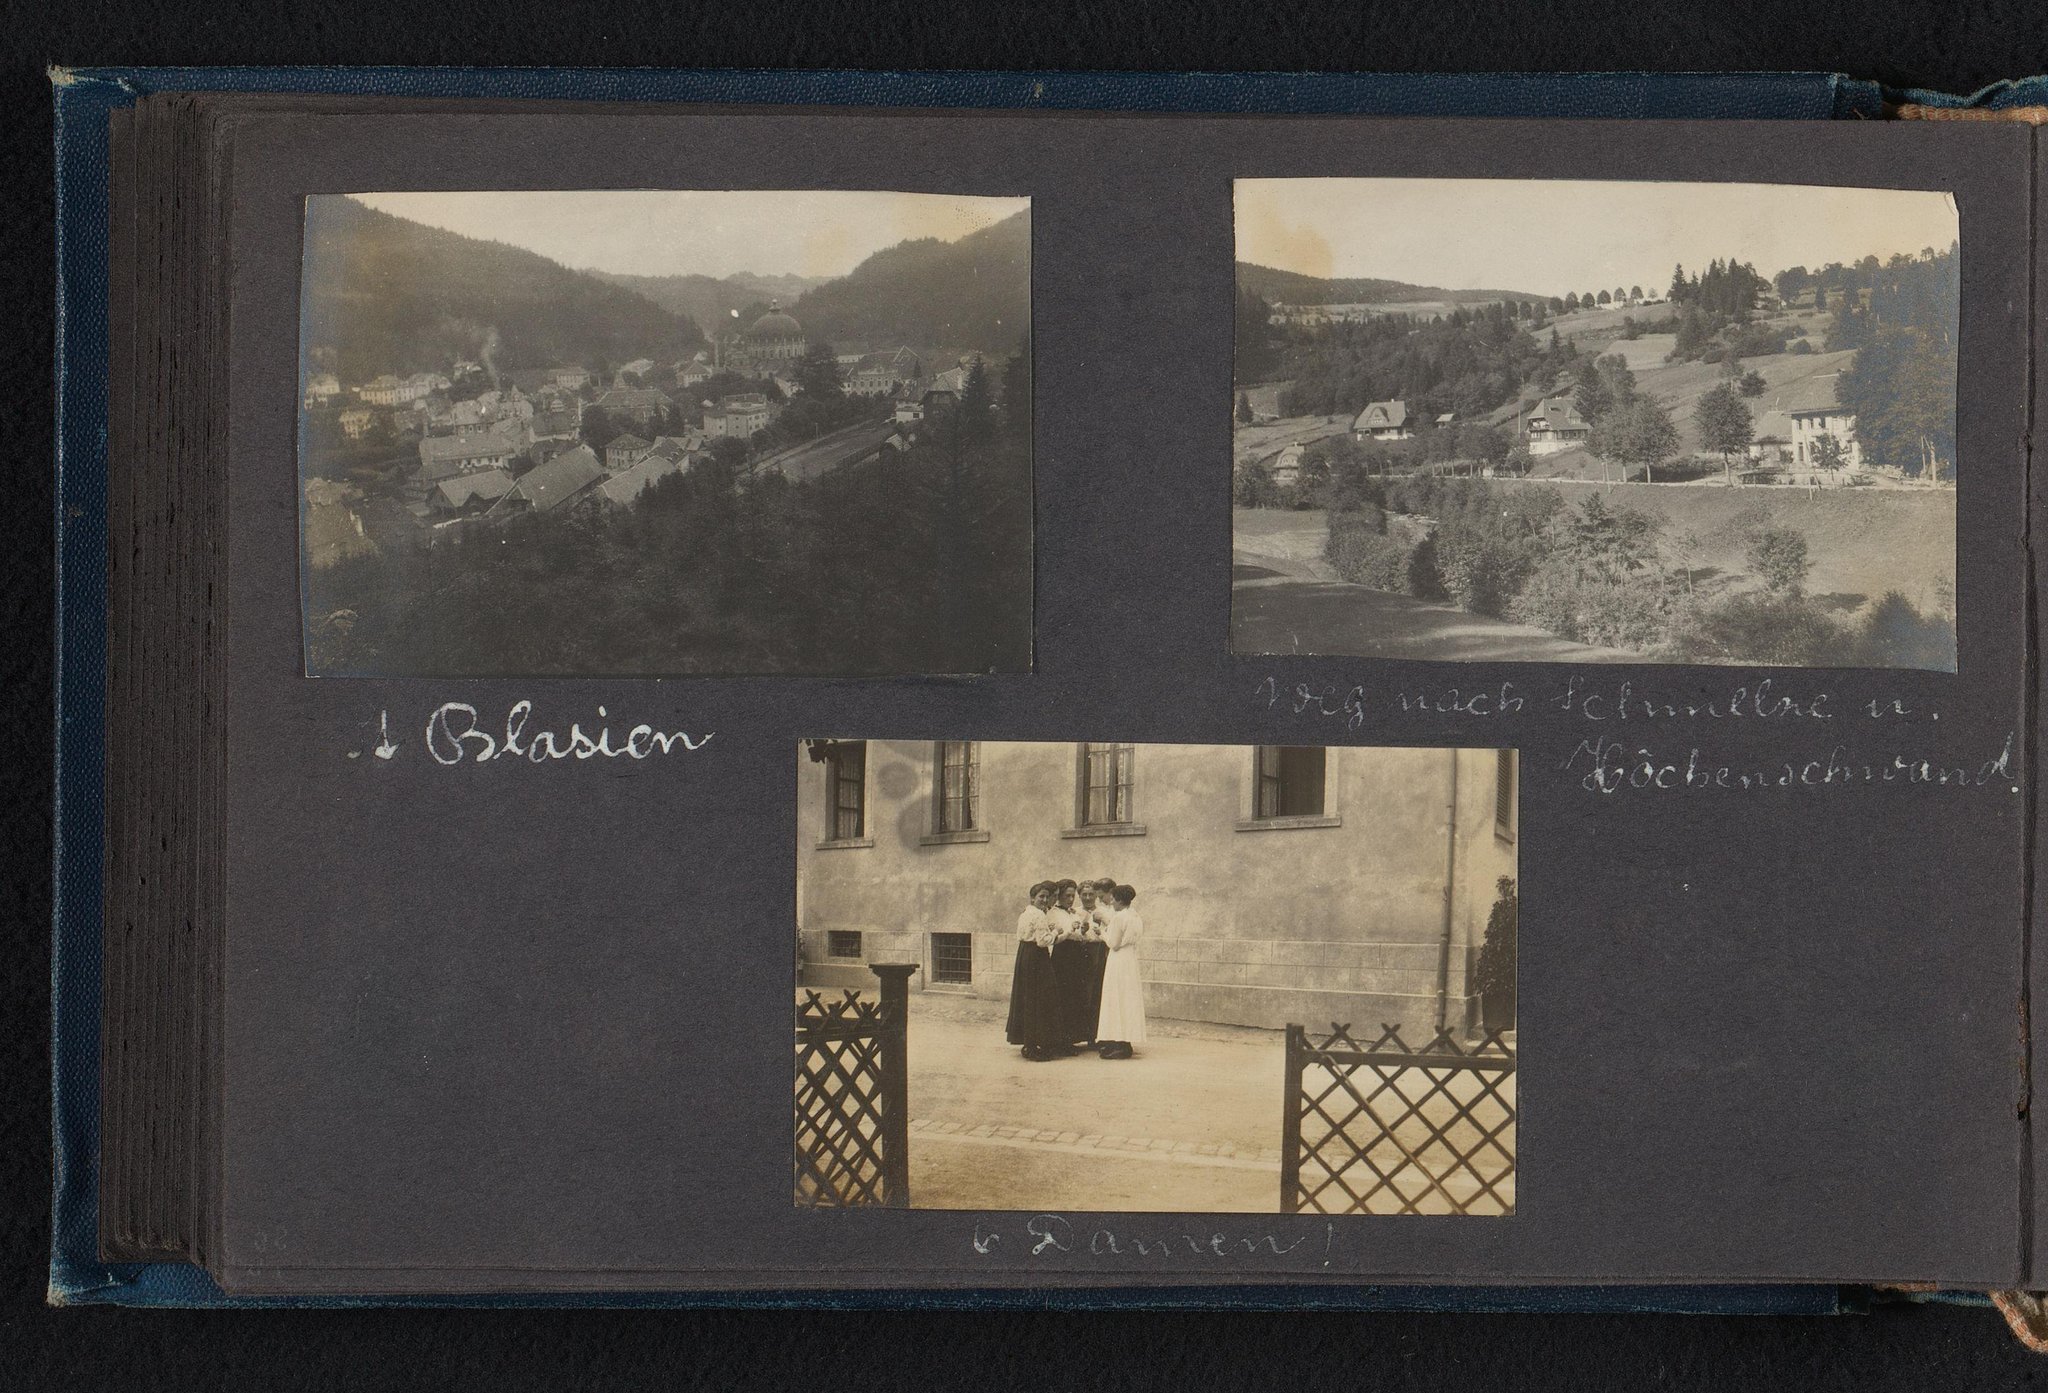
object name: photograph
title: Vakantie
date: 1916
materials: paper, photographic support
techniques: gelatin silver print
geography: germany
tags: else wachenheimer-moos, low hill country, germany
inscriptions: inscription: ‘St. Blasien / Weg nach Sch... u. Hôchenschwand / Damen!’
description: Albumblad met drie foto's van een vakantie in Zuid-Duitsland. Onderdeel van het fotoalbum van Else Wachenheimer-Moos en haar broers Arthur en Willy Moos en anderen in de periode 1913-1918.